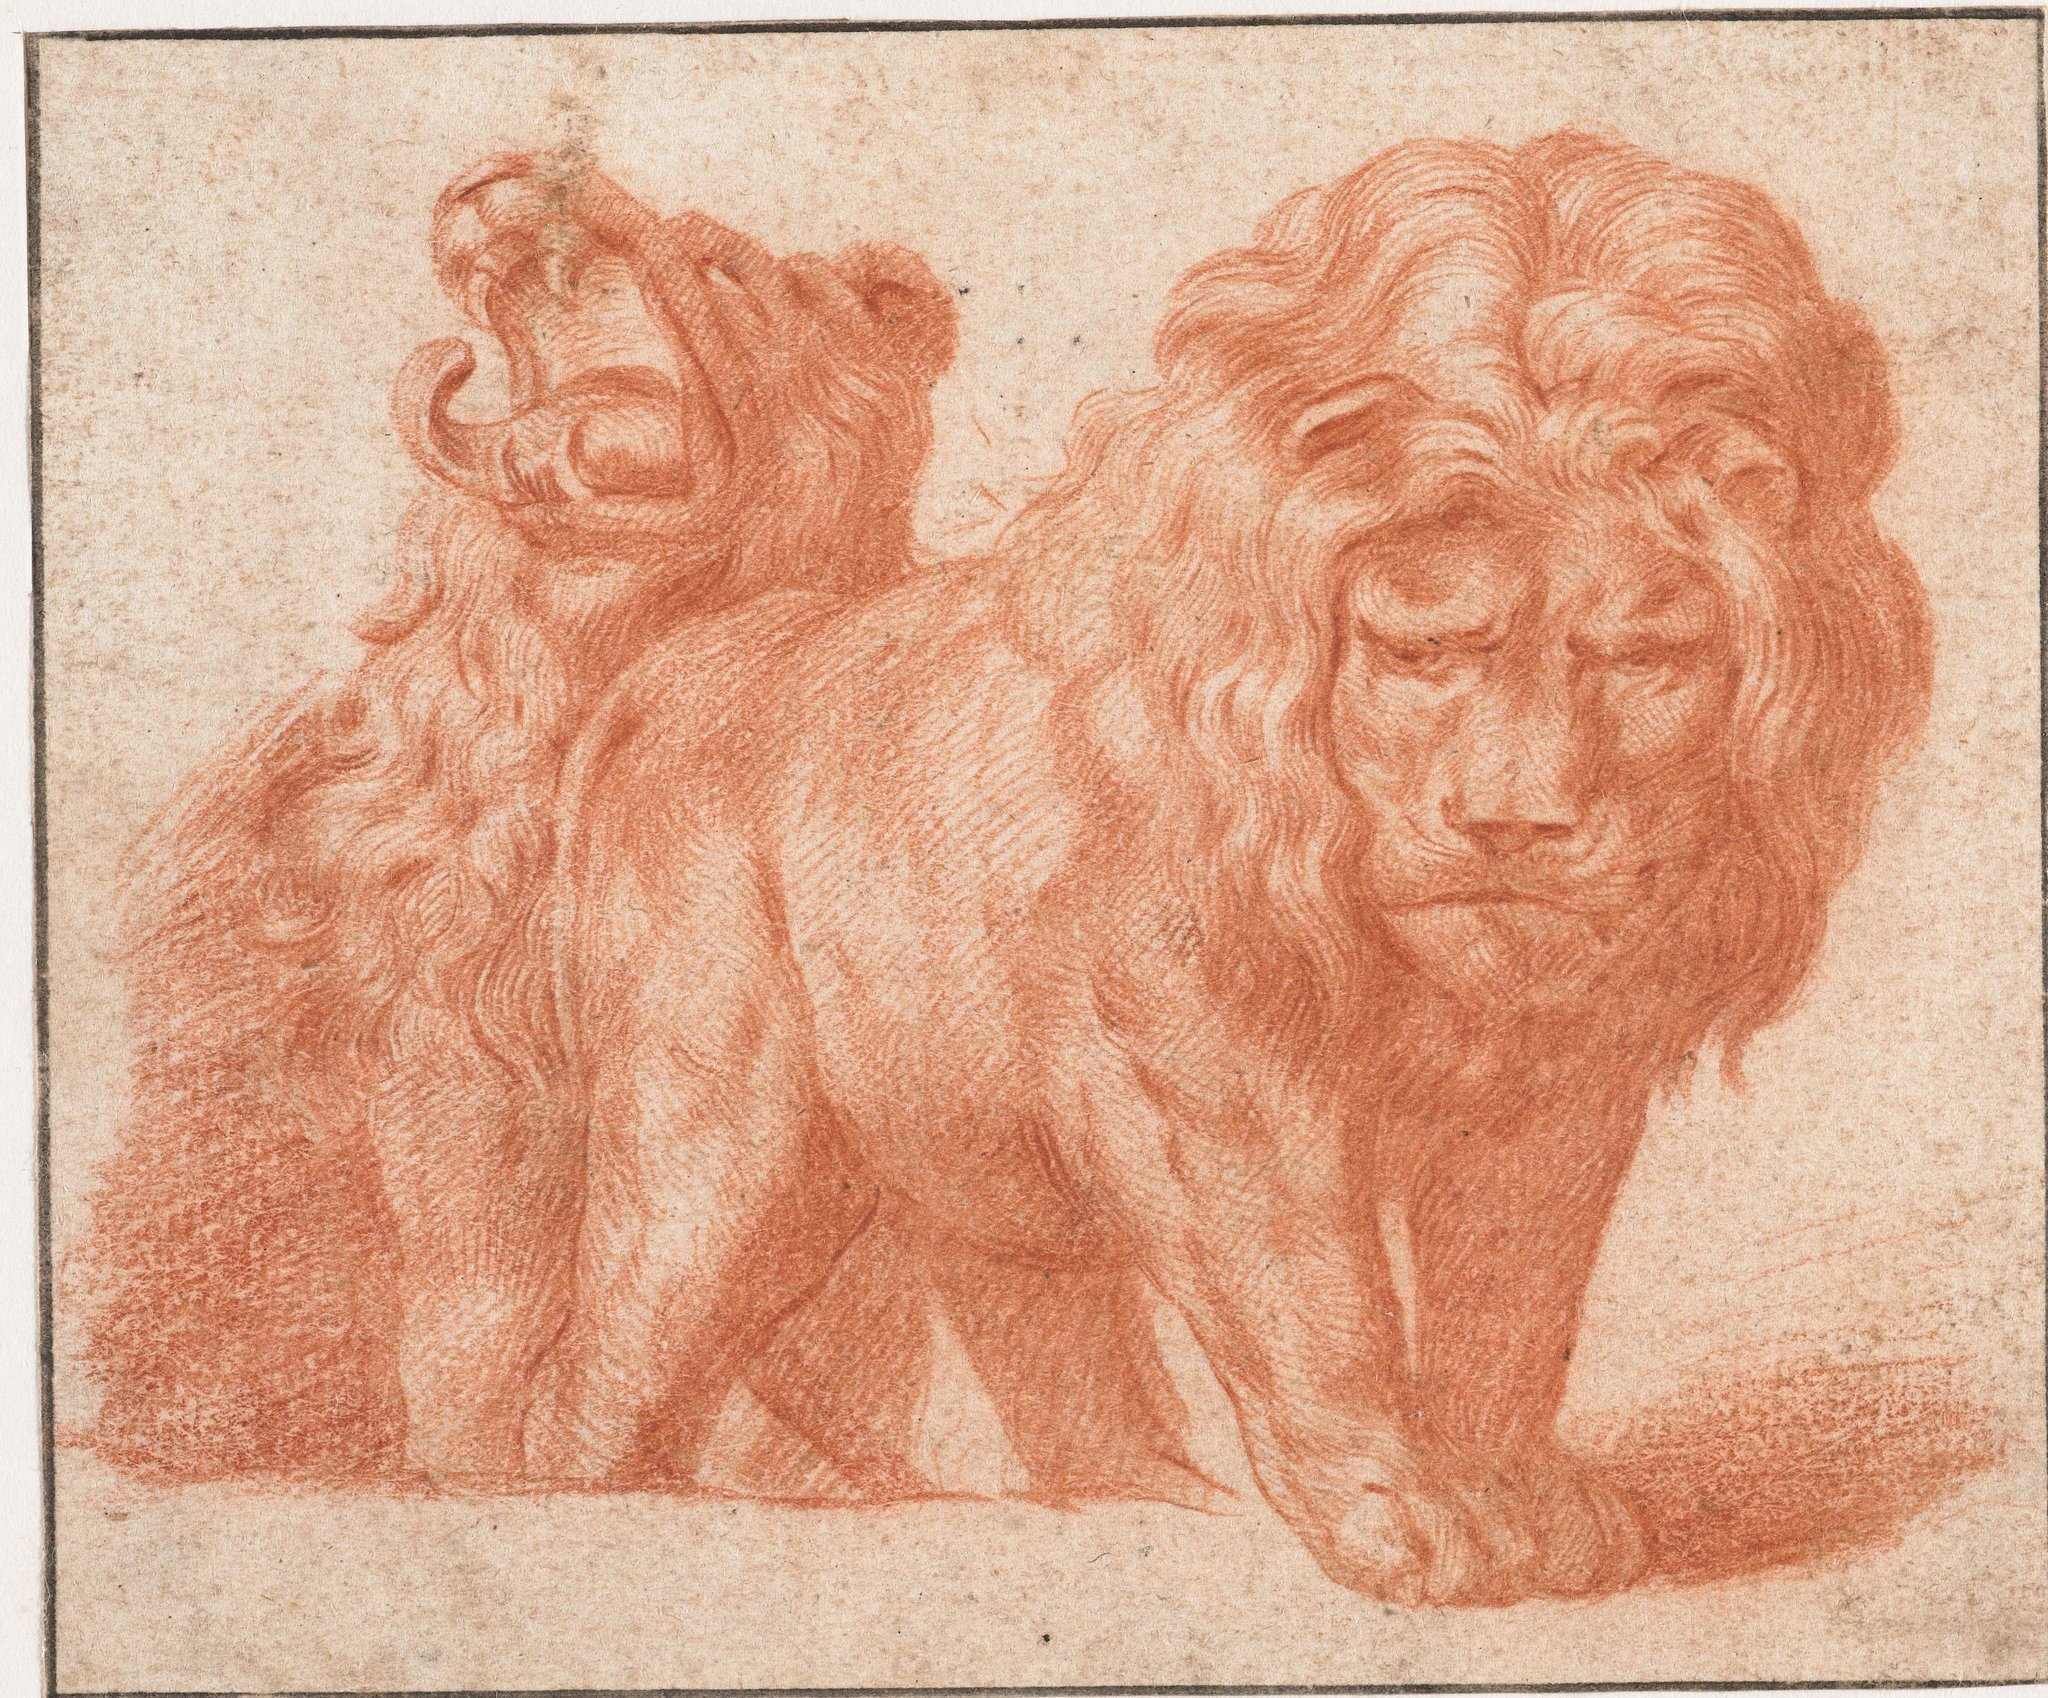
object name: drawing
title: Twee leeuwen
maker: peter paul rubens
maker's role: draughtsman, painter, print maker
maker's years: 1577-1640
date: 1650-1690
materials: chalk, paper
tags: beasts of prey, predatory animals: lion